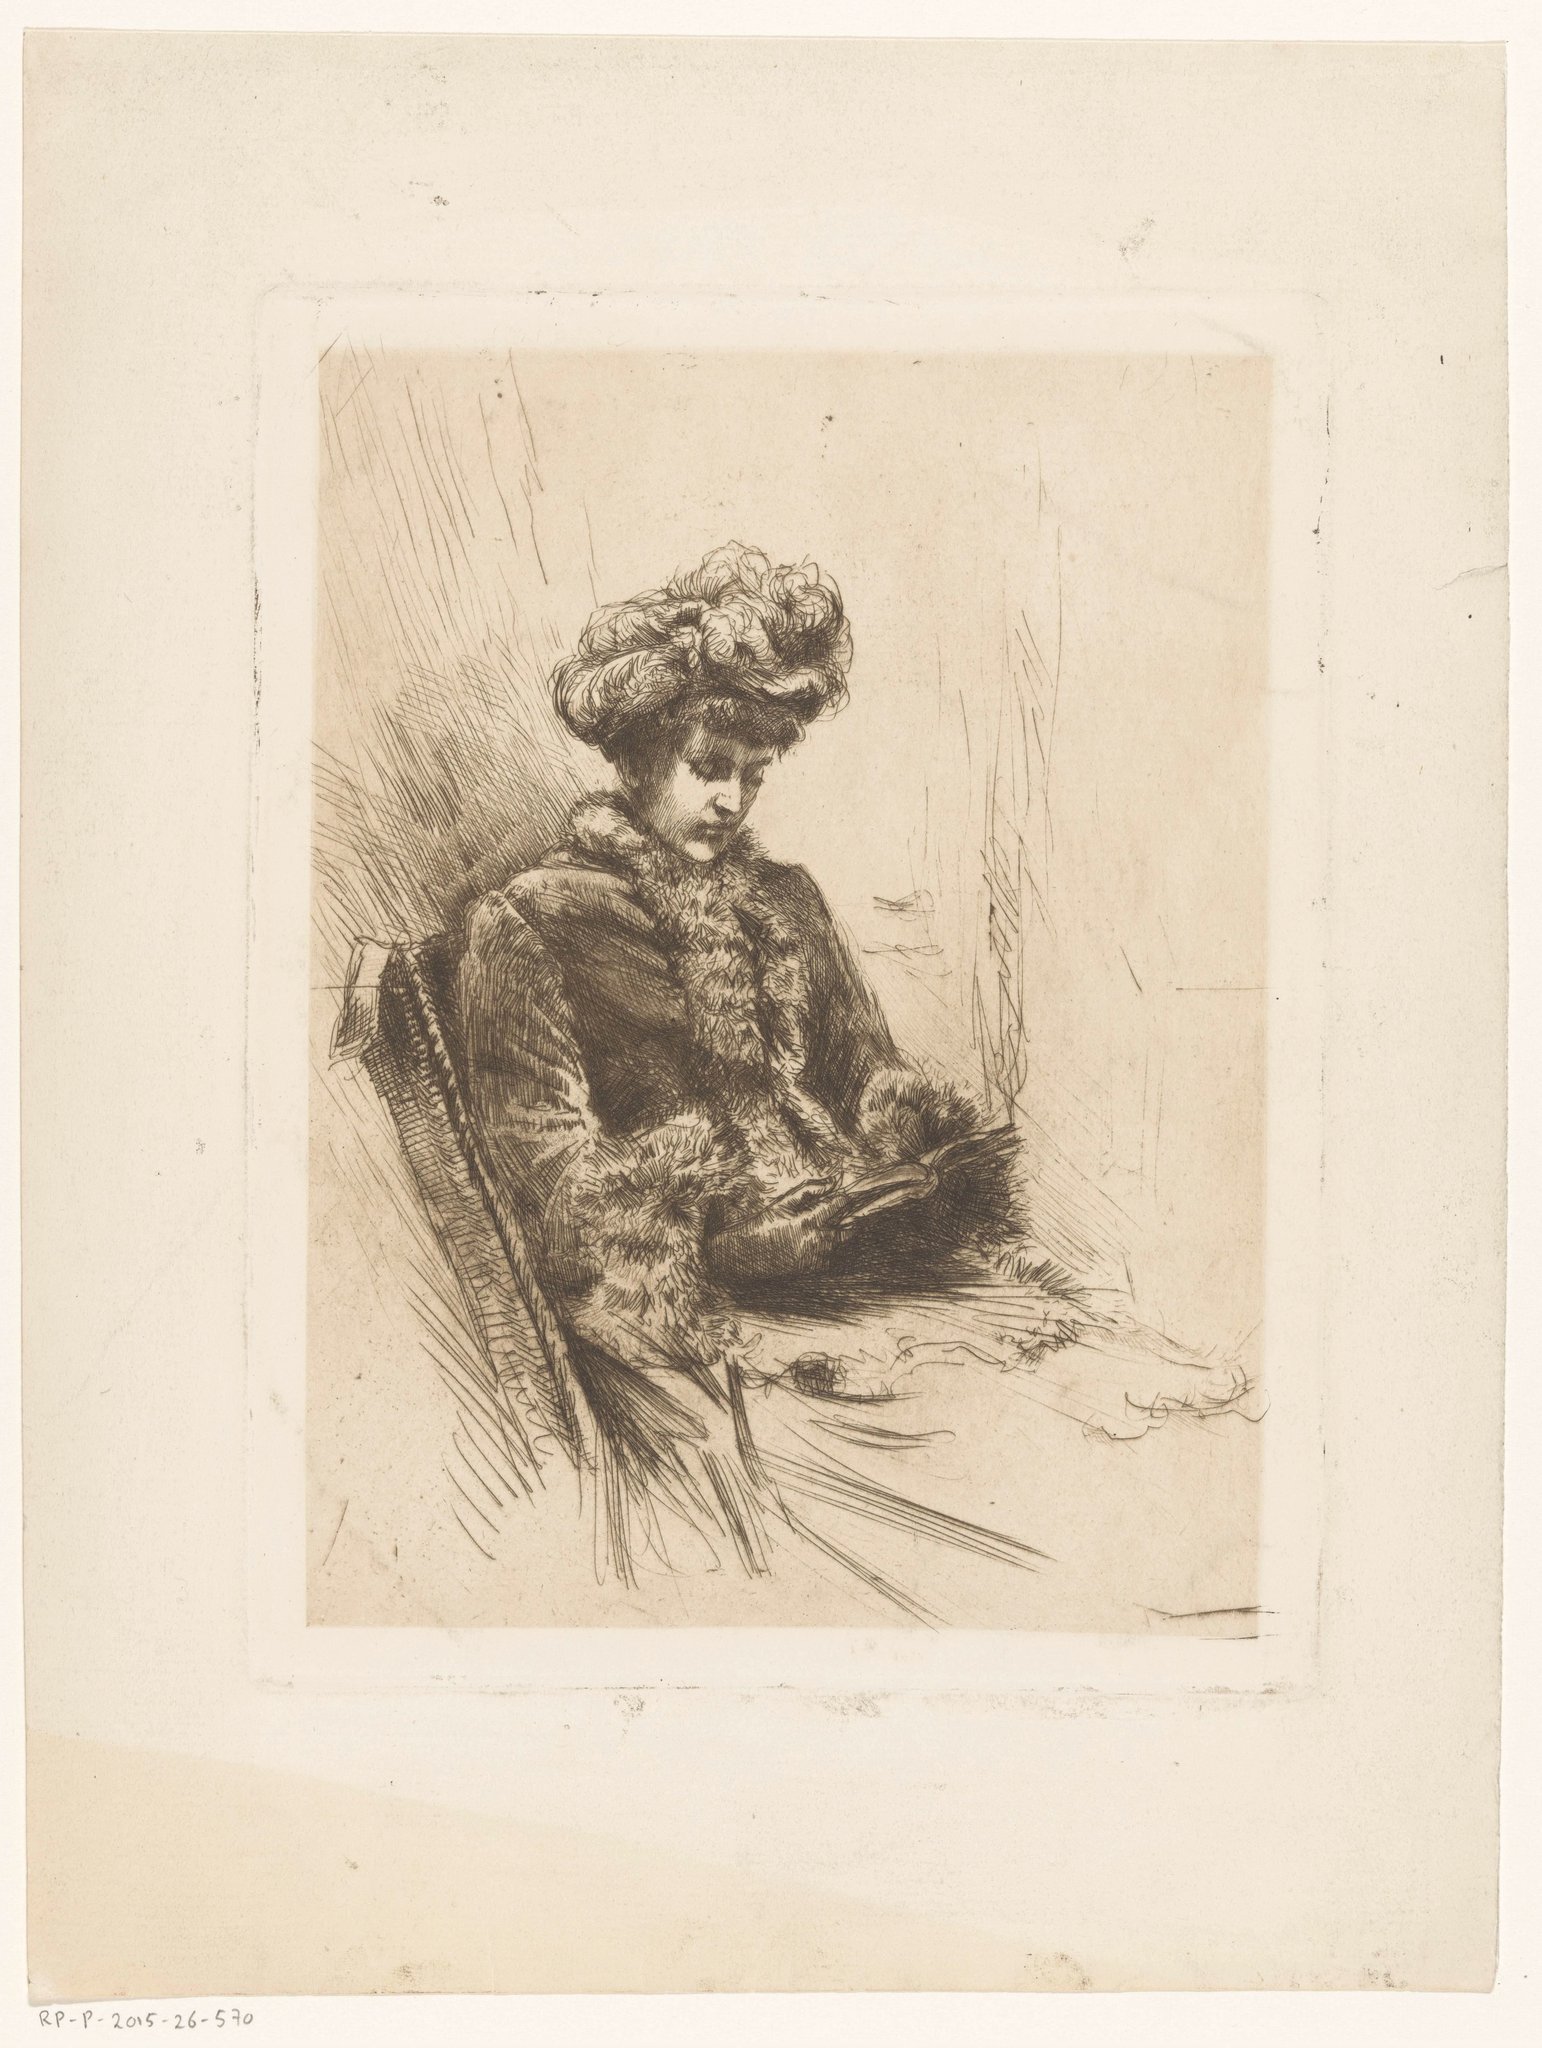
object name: print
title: Lezende vrouw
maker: Anonymous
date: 1875-1925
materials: paper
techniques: drypoint, intaglio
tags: book, newspaper, news-sheet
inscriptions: collector's mark: Lugt 4780, collector's mark: Lugt 2228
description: Zittende vrouw met hoed en bontmantel, in haar handen houdt ze een boek vast.